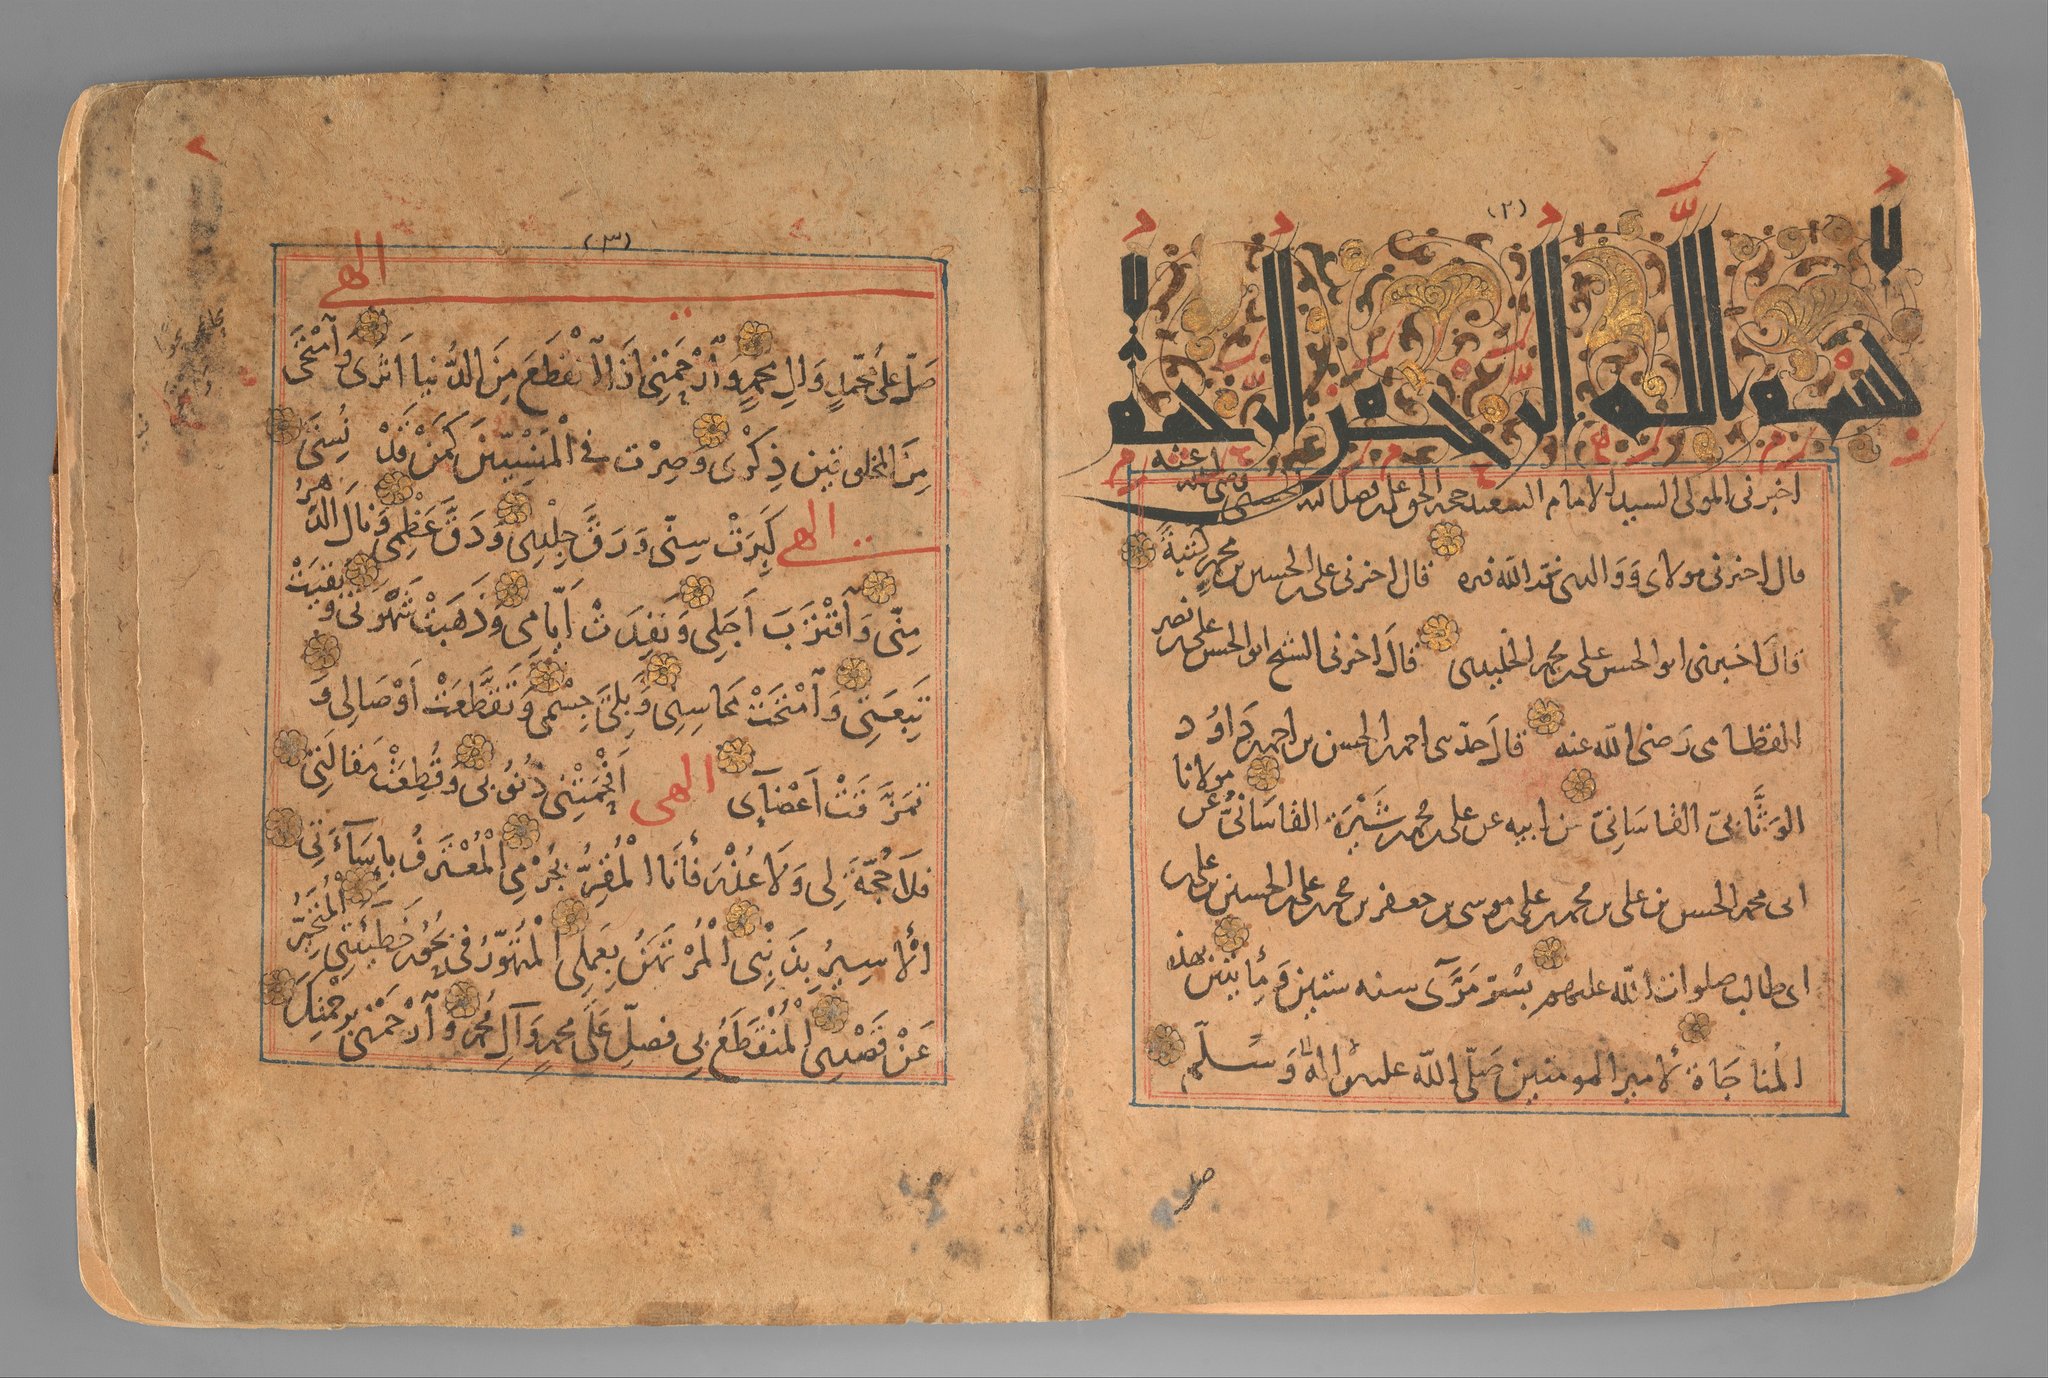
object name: non illustrated manuscript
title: Munajat (Confidential Talks) of 'Ali ibn Abu-Talib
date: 1200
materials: gold, ink, leather, paper, watercolor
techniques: bookbinding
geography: iraq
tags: calligraphy